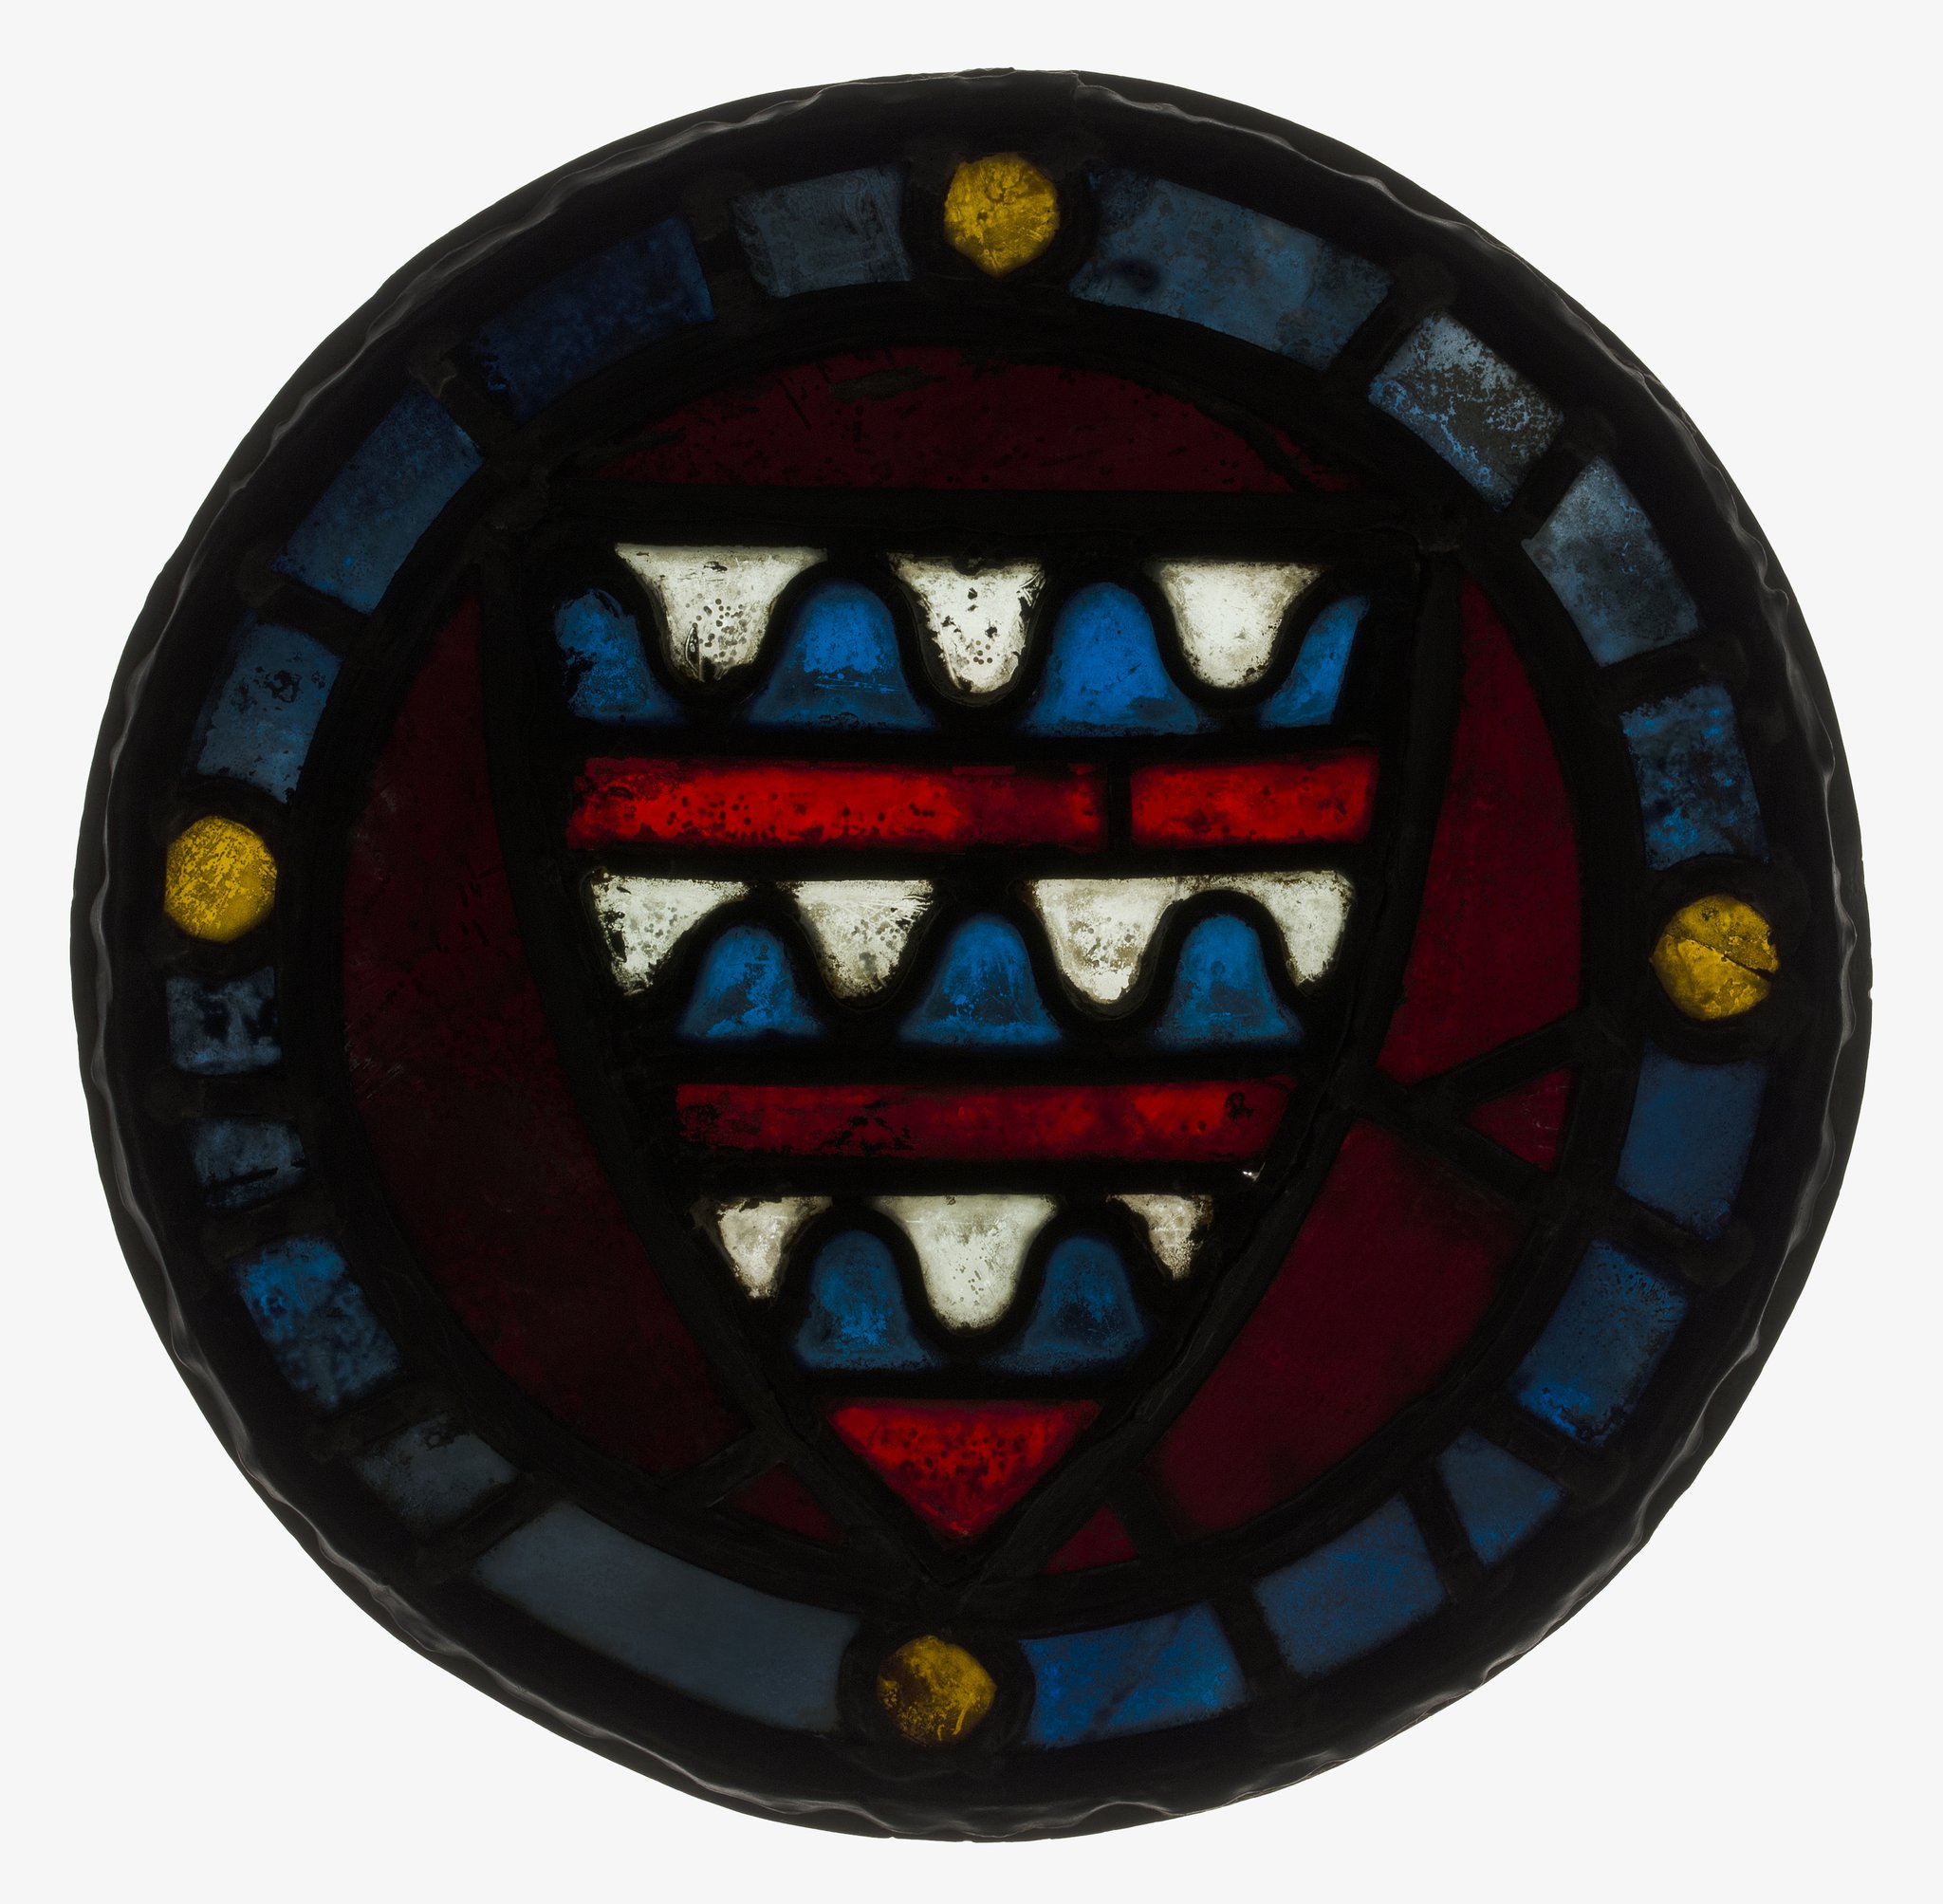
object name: roundel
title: Roundel with the Arms of Coucy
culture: british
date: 1360-1377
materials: glass, metal, paint